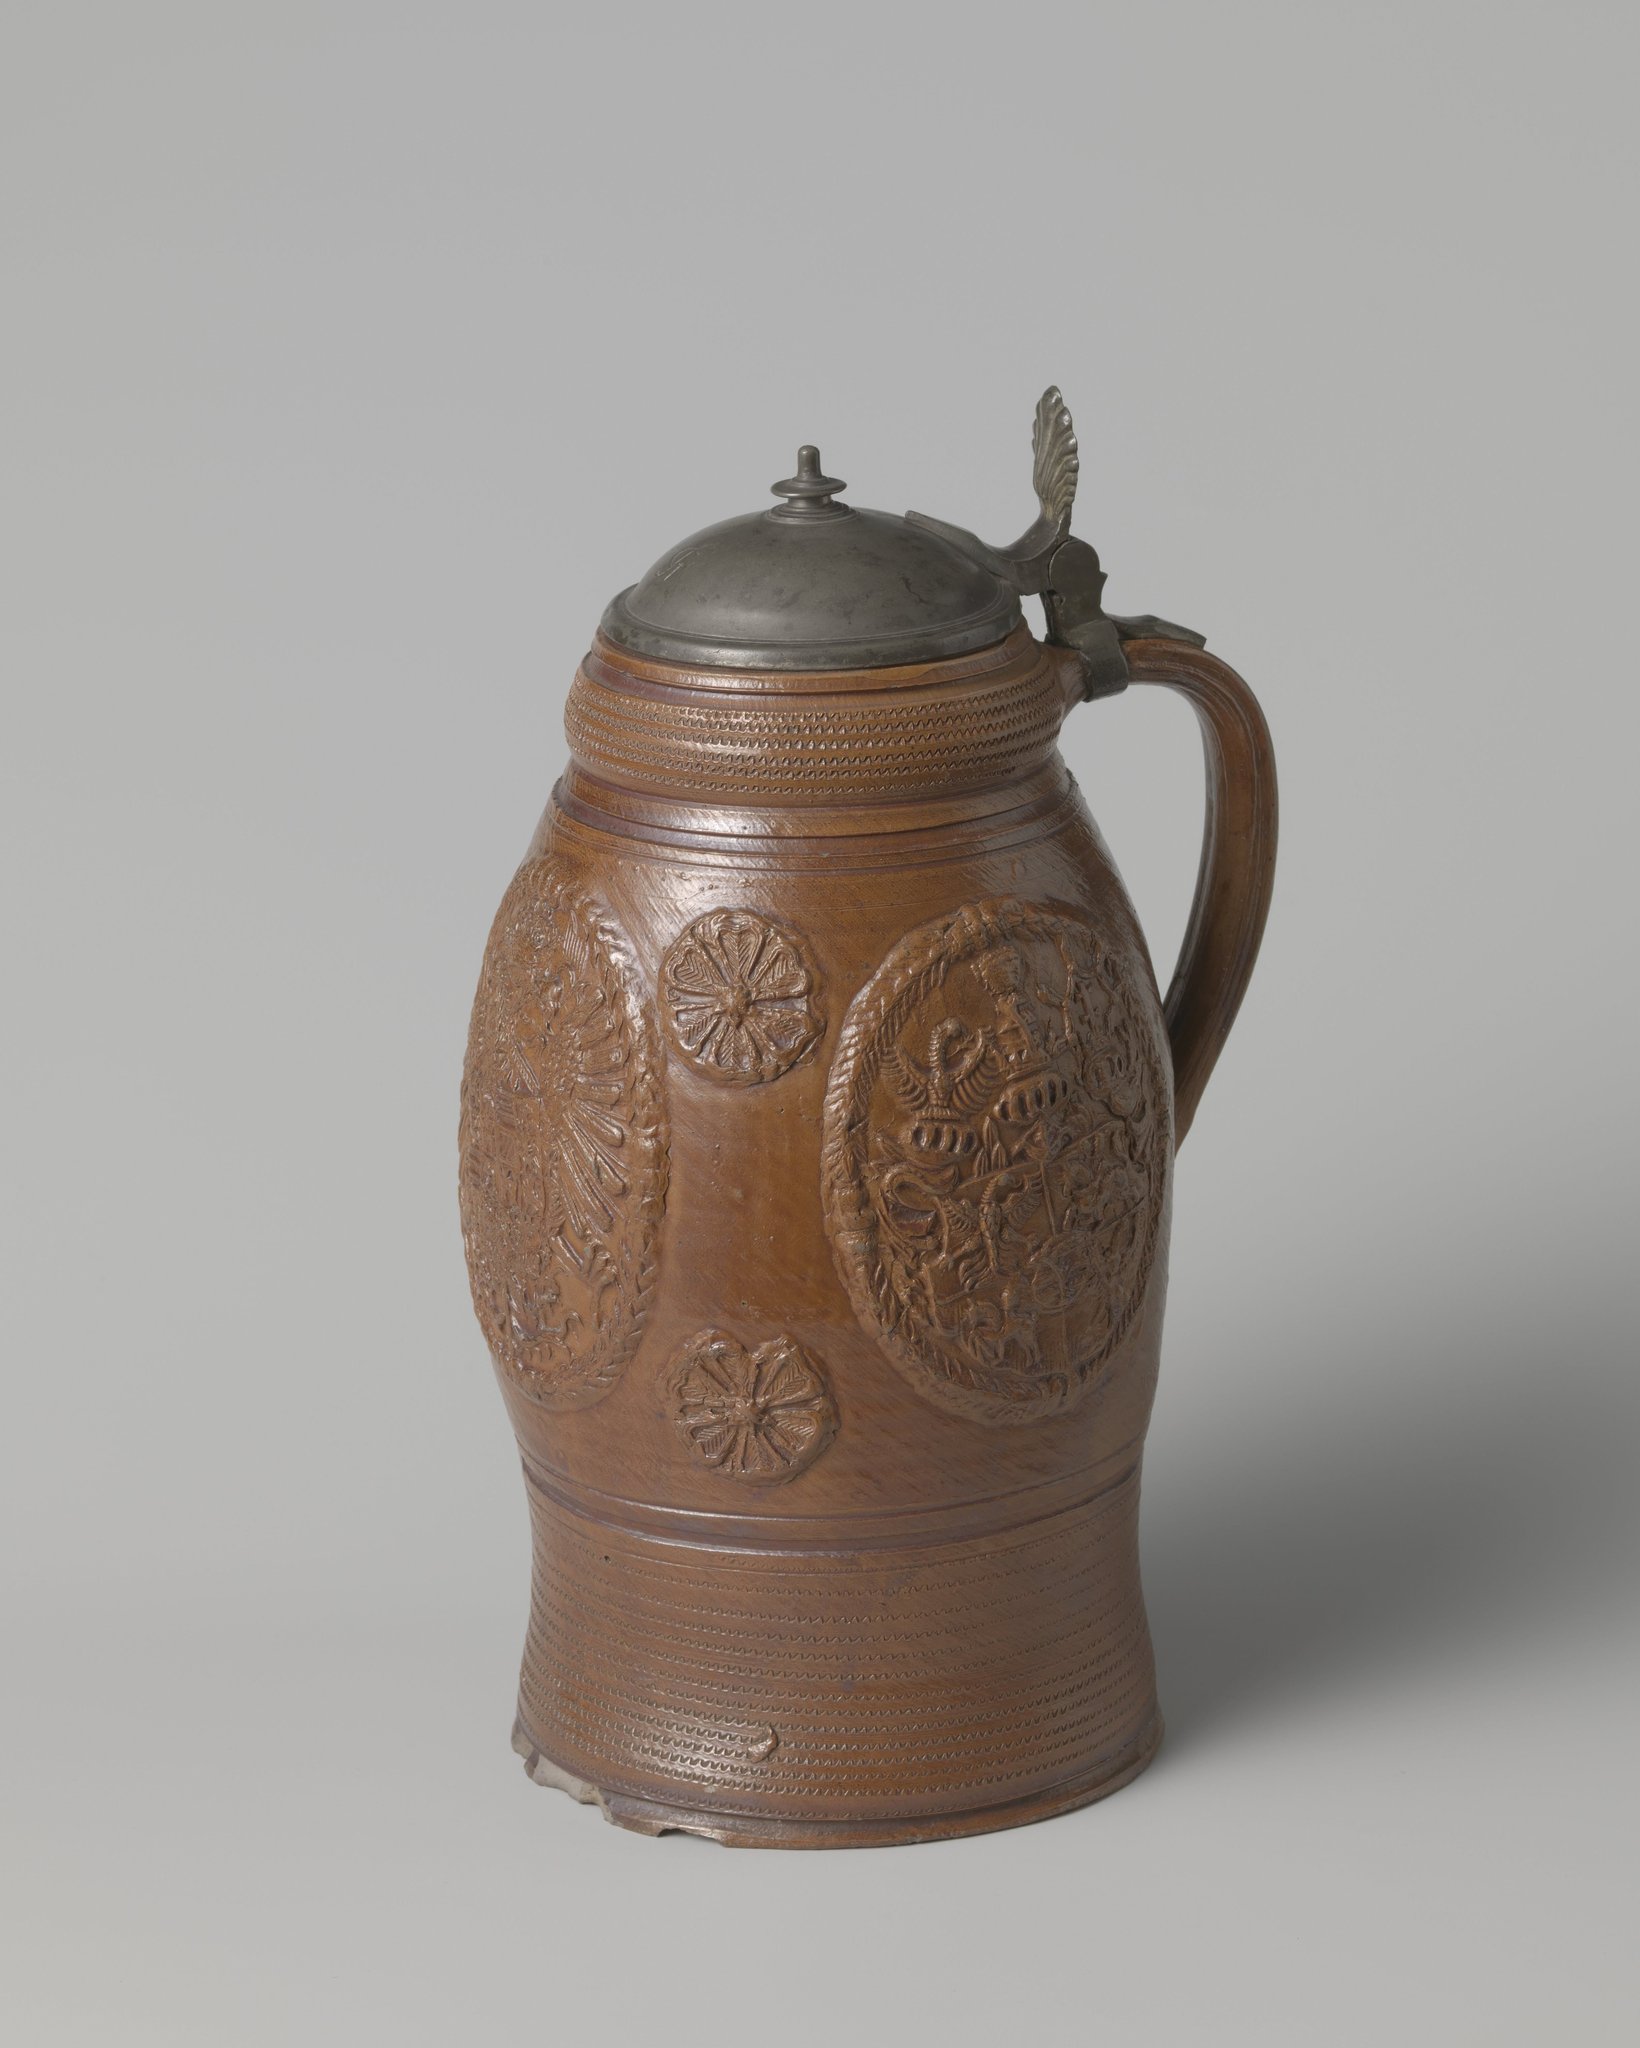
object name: stave tankard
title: Tankard with the coat of arms of Saxony-Poland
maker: Anonymous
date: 1700-1730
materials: engobe, glaze, stoneware, tin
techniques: firing, forming, relief, turning, vitrification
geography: waldenburg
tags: ghent, charles v (holy roman emperor and king of spain)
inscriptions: mark: ‘C.F.T[?]’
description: Tankard with three medallions with the arms of the Emperor Charles V flanked by those of Augustus the Strong as Elector of Saxony. Waldenburg, c. 1700 - 1730.